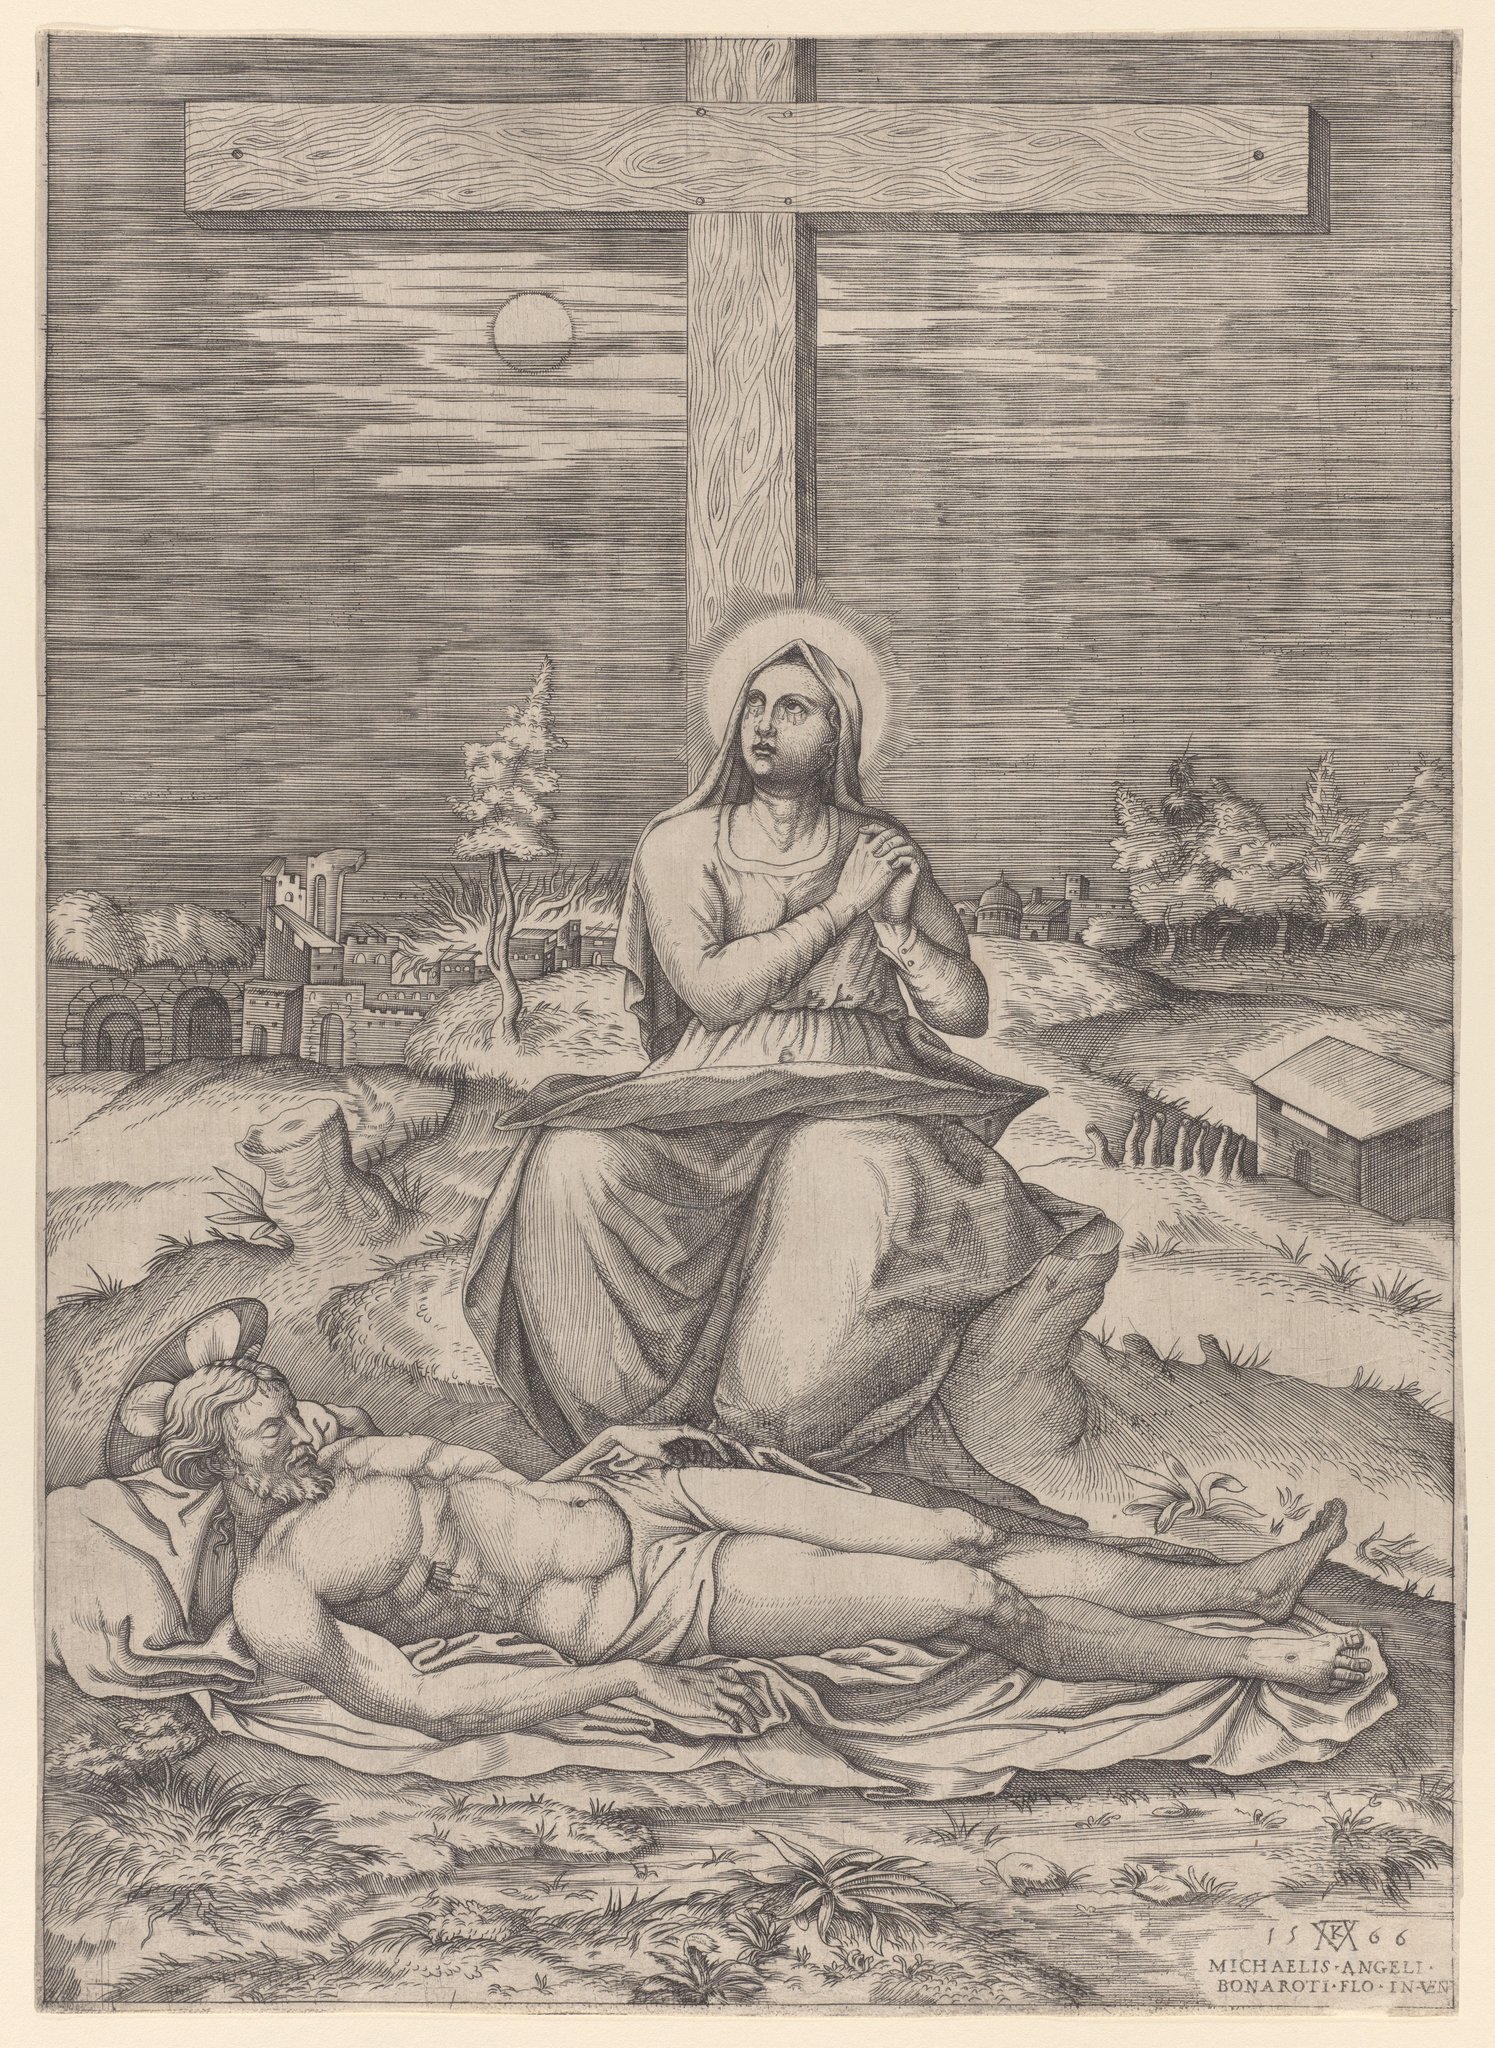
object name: print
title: The Lamentation of the Virgin Beneath the Cross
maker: mario cartaro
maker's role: artist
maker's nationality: italian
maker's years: 1557-1620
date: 1566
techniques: engraving